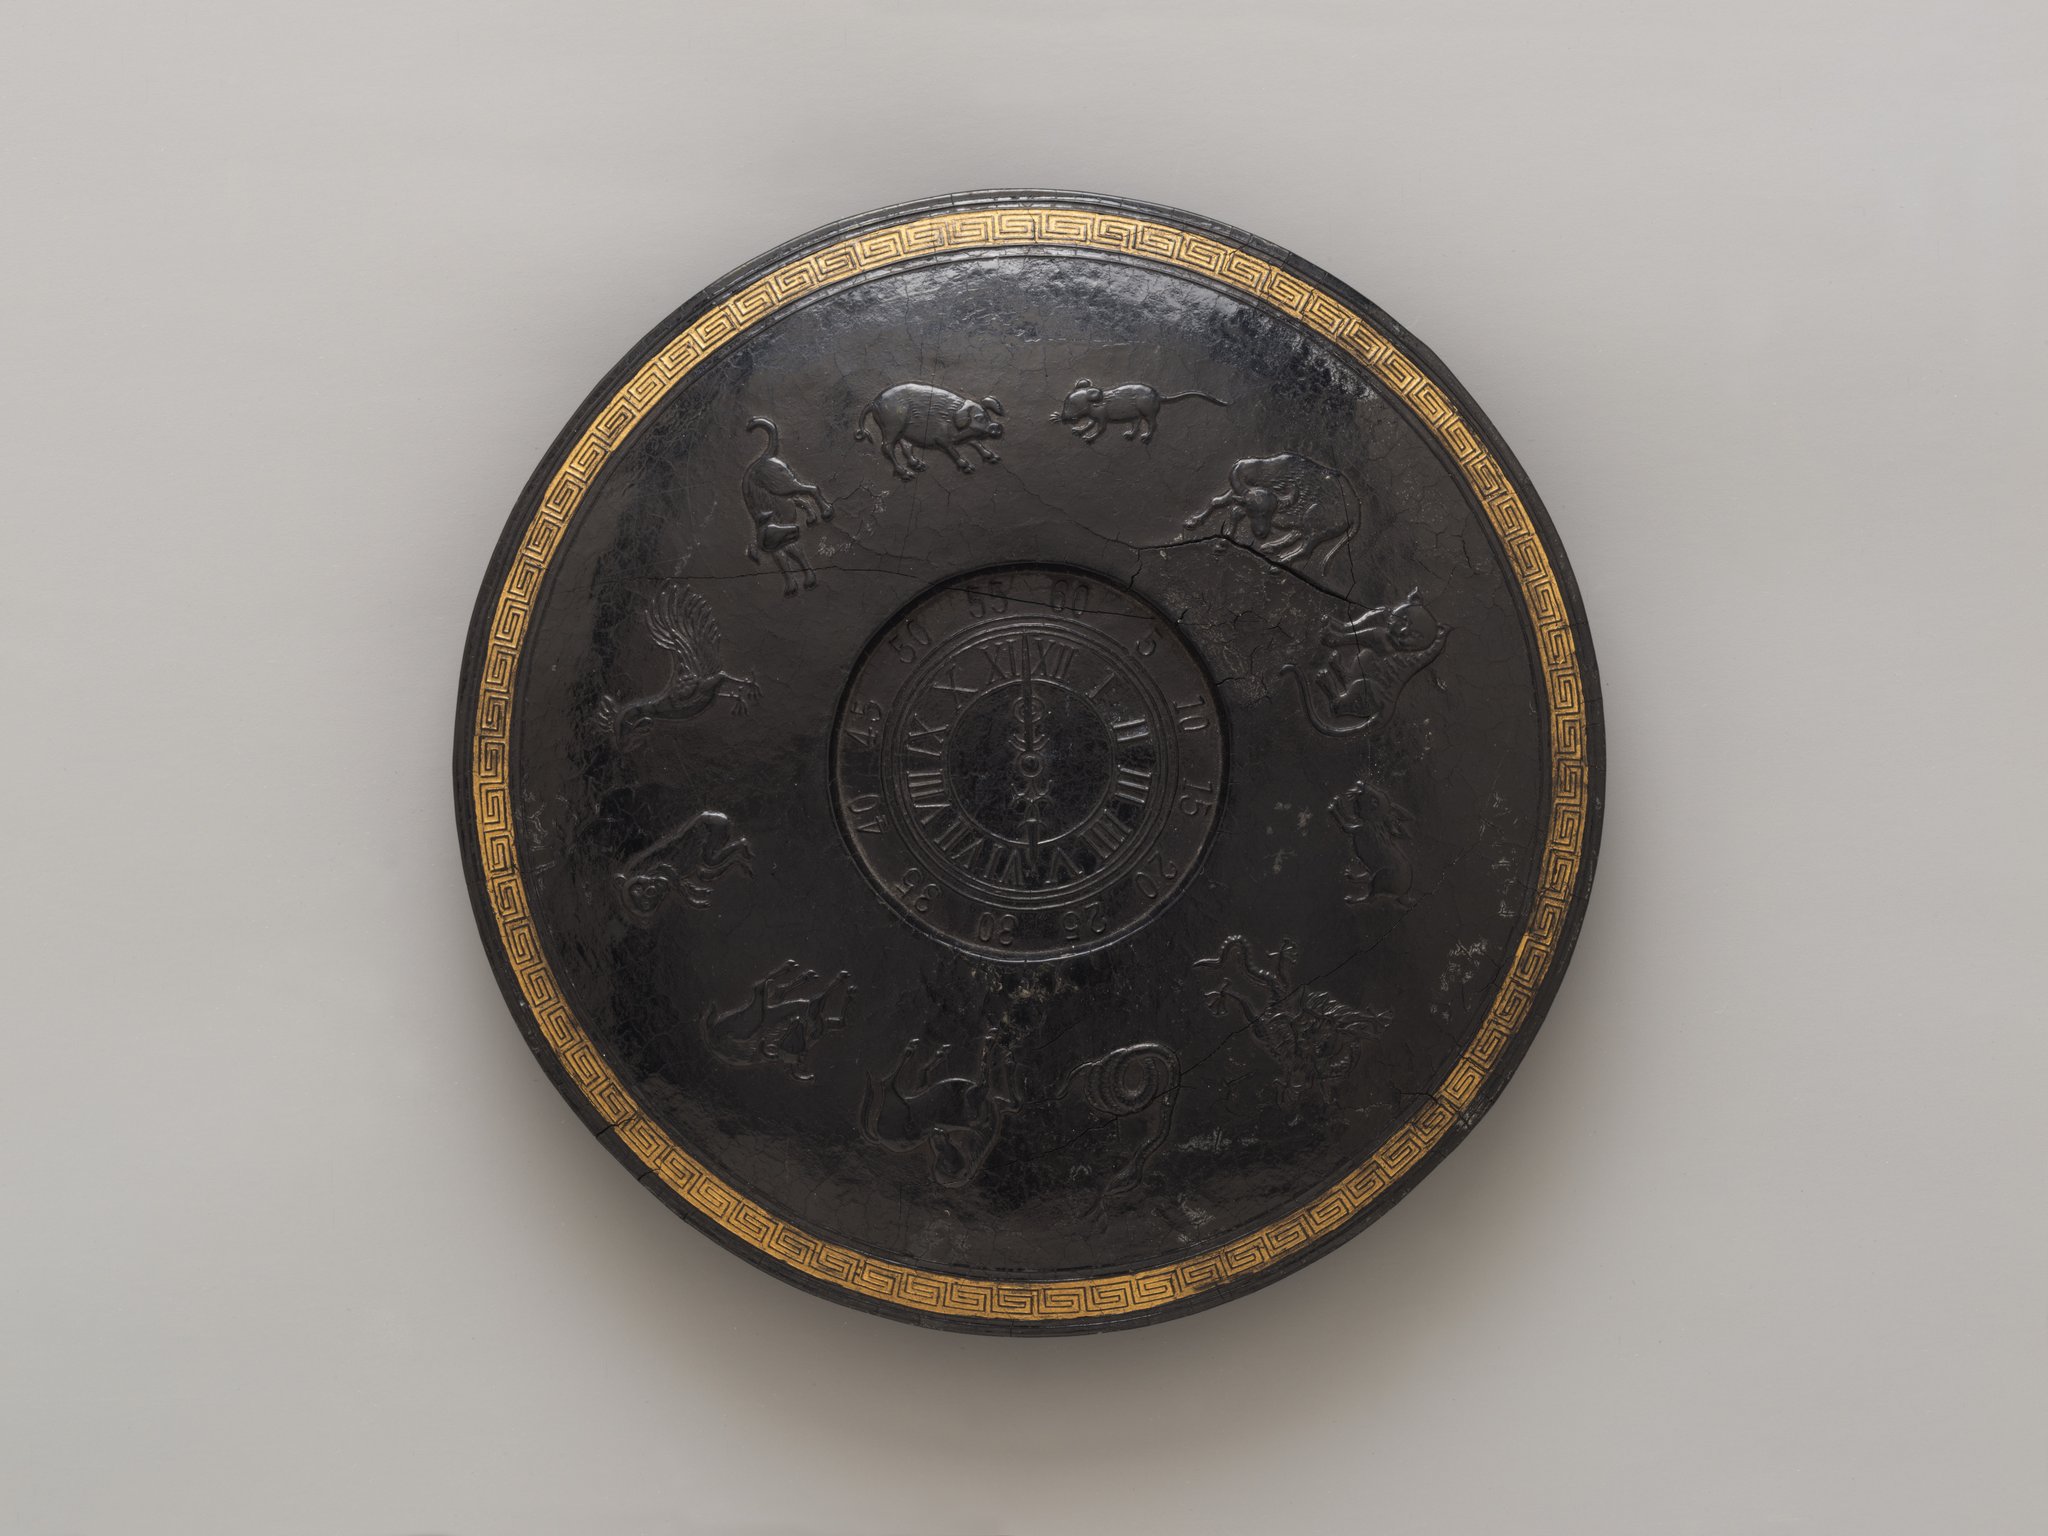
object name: ink cake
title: Ink cake with cyclical imagery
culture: chinese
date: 1867-1933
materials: gold, ink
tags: animals,dragons,dogs,goats,horses,monkeys,pigs,rabbits,rats,snakes,tigers,zodiac,clocks,ox